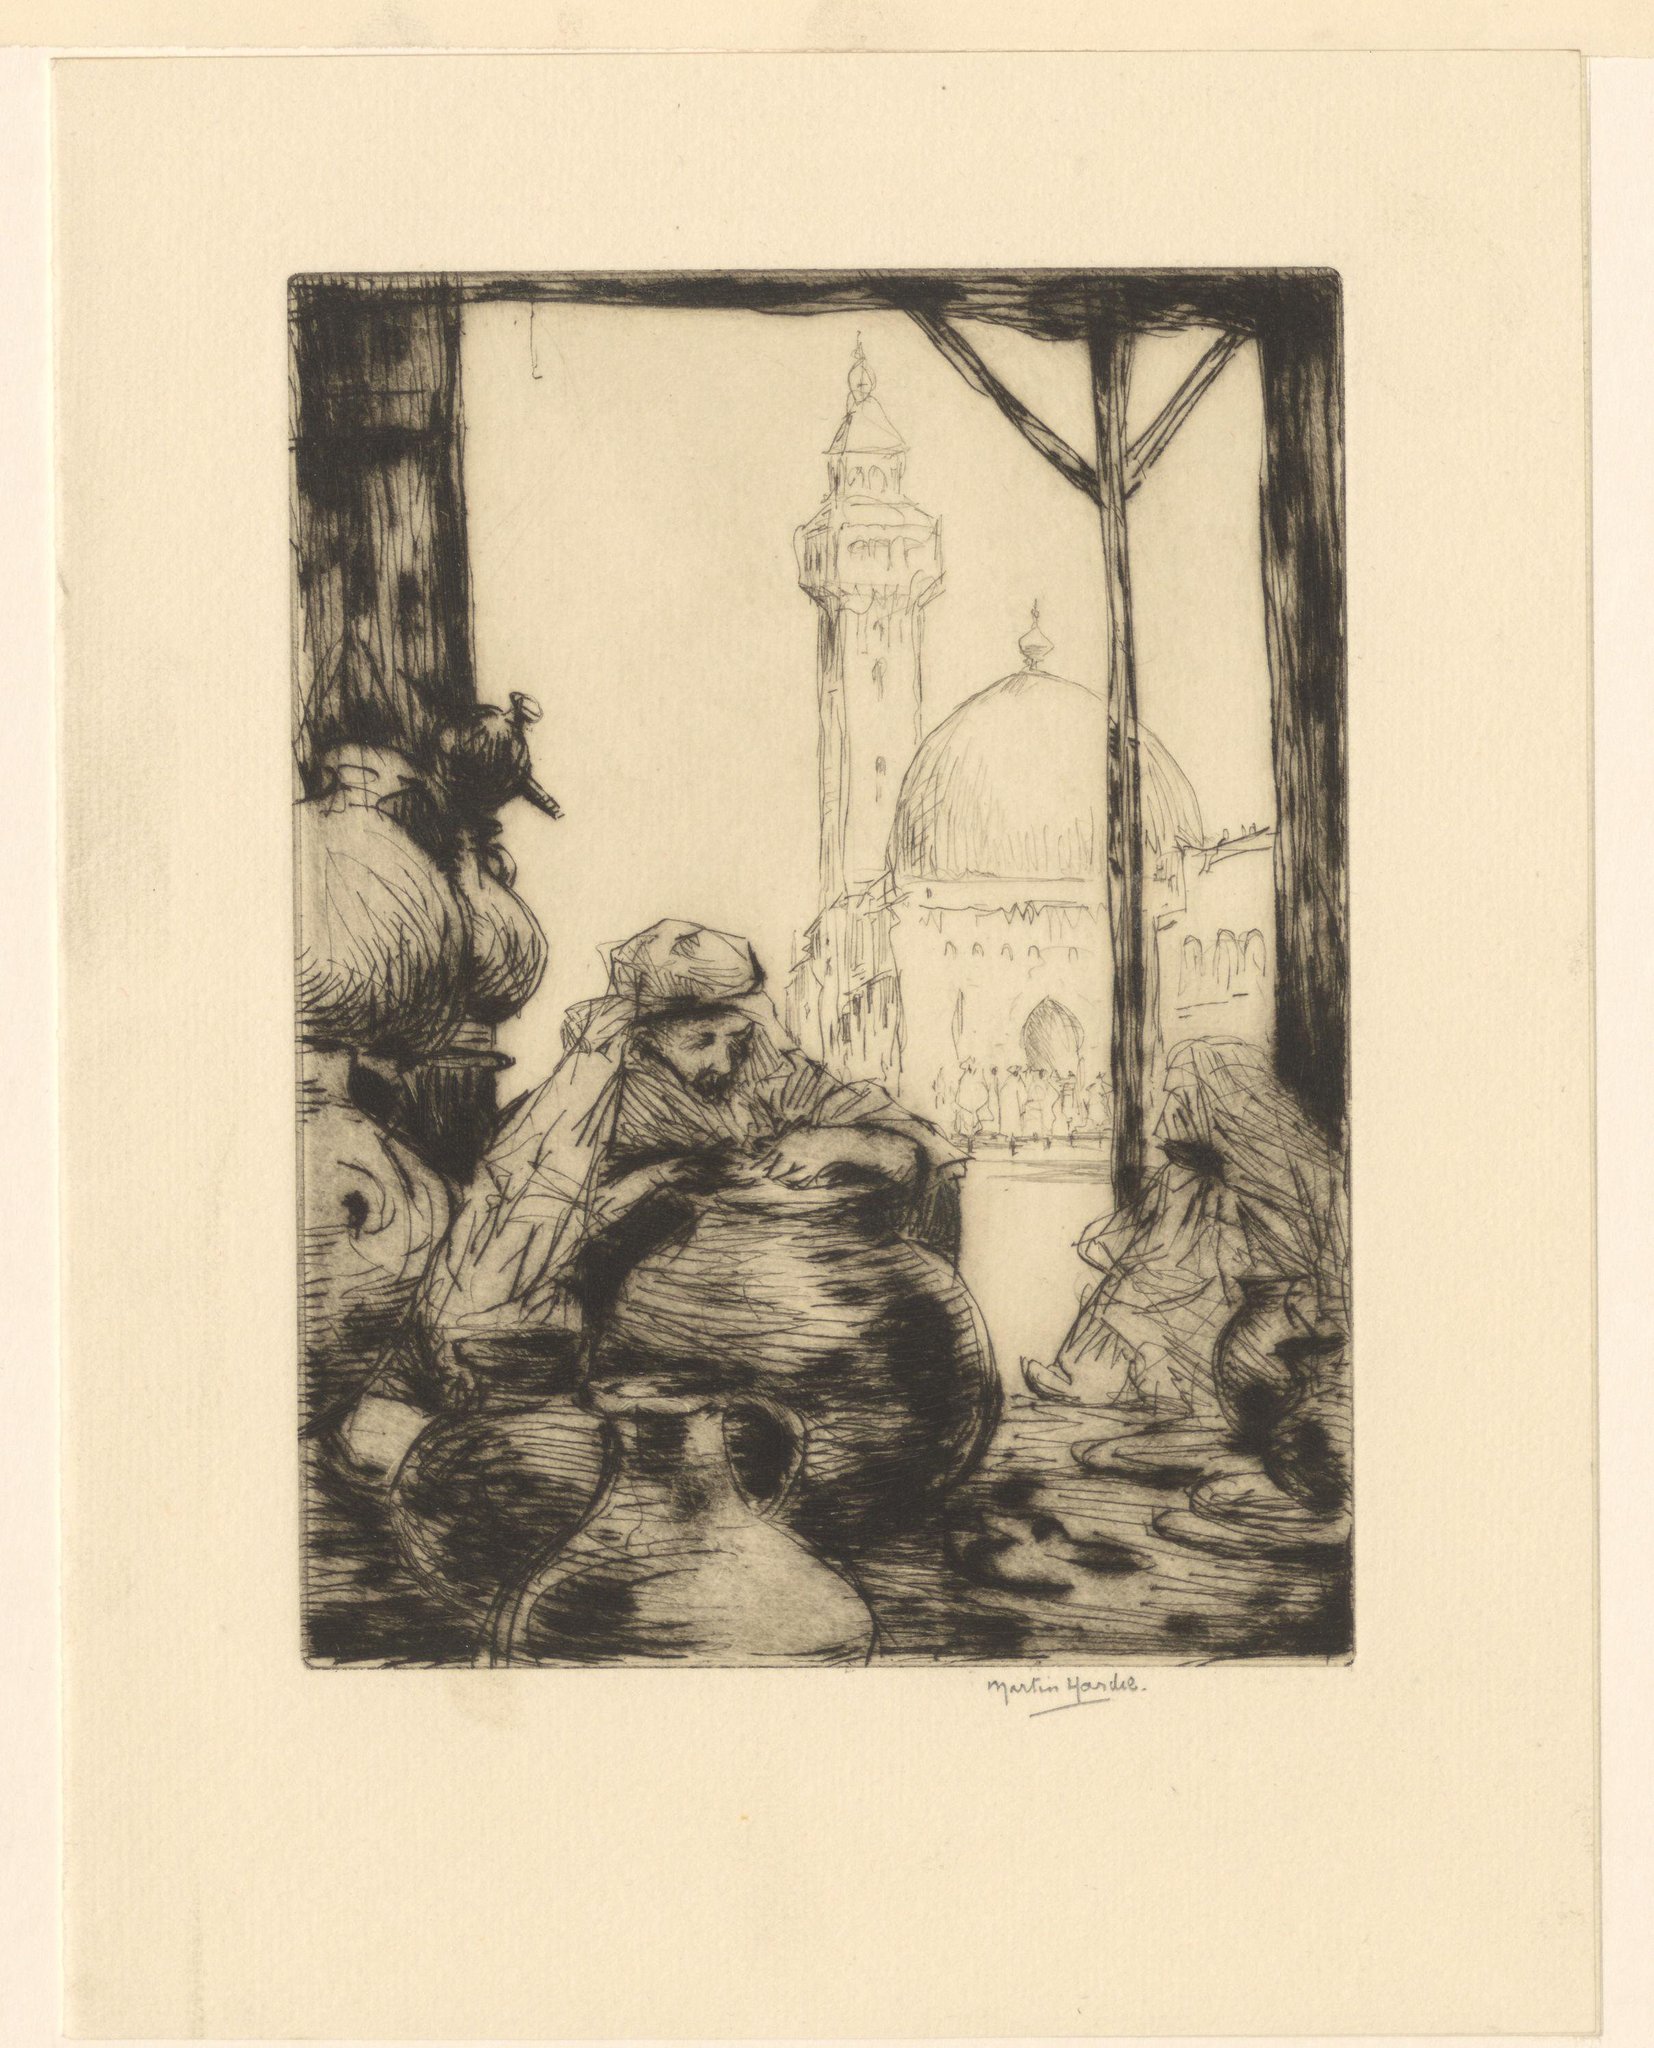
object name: menu, menukaart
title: Man met potten nabij een moskee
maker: martin hardie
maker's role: print maker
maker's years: 1875-1952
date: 1922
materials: paper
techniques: drypoint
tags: indoor recreation (+ menu, bill of fare), temple, shrine ~ islam, mohammedanism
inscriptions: annotation: ‘Martin Hardie’, collector's mark: Lugt 2228, collector's mark: Lugt 2760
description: Deze prent is volgens notities in de catalogus ontworpen als menukaart voor een diner van de Omar Khayyam Club.